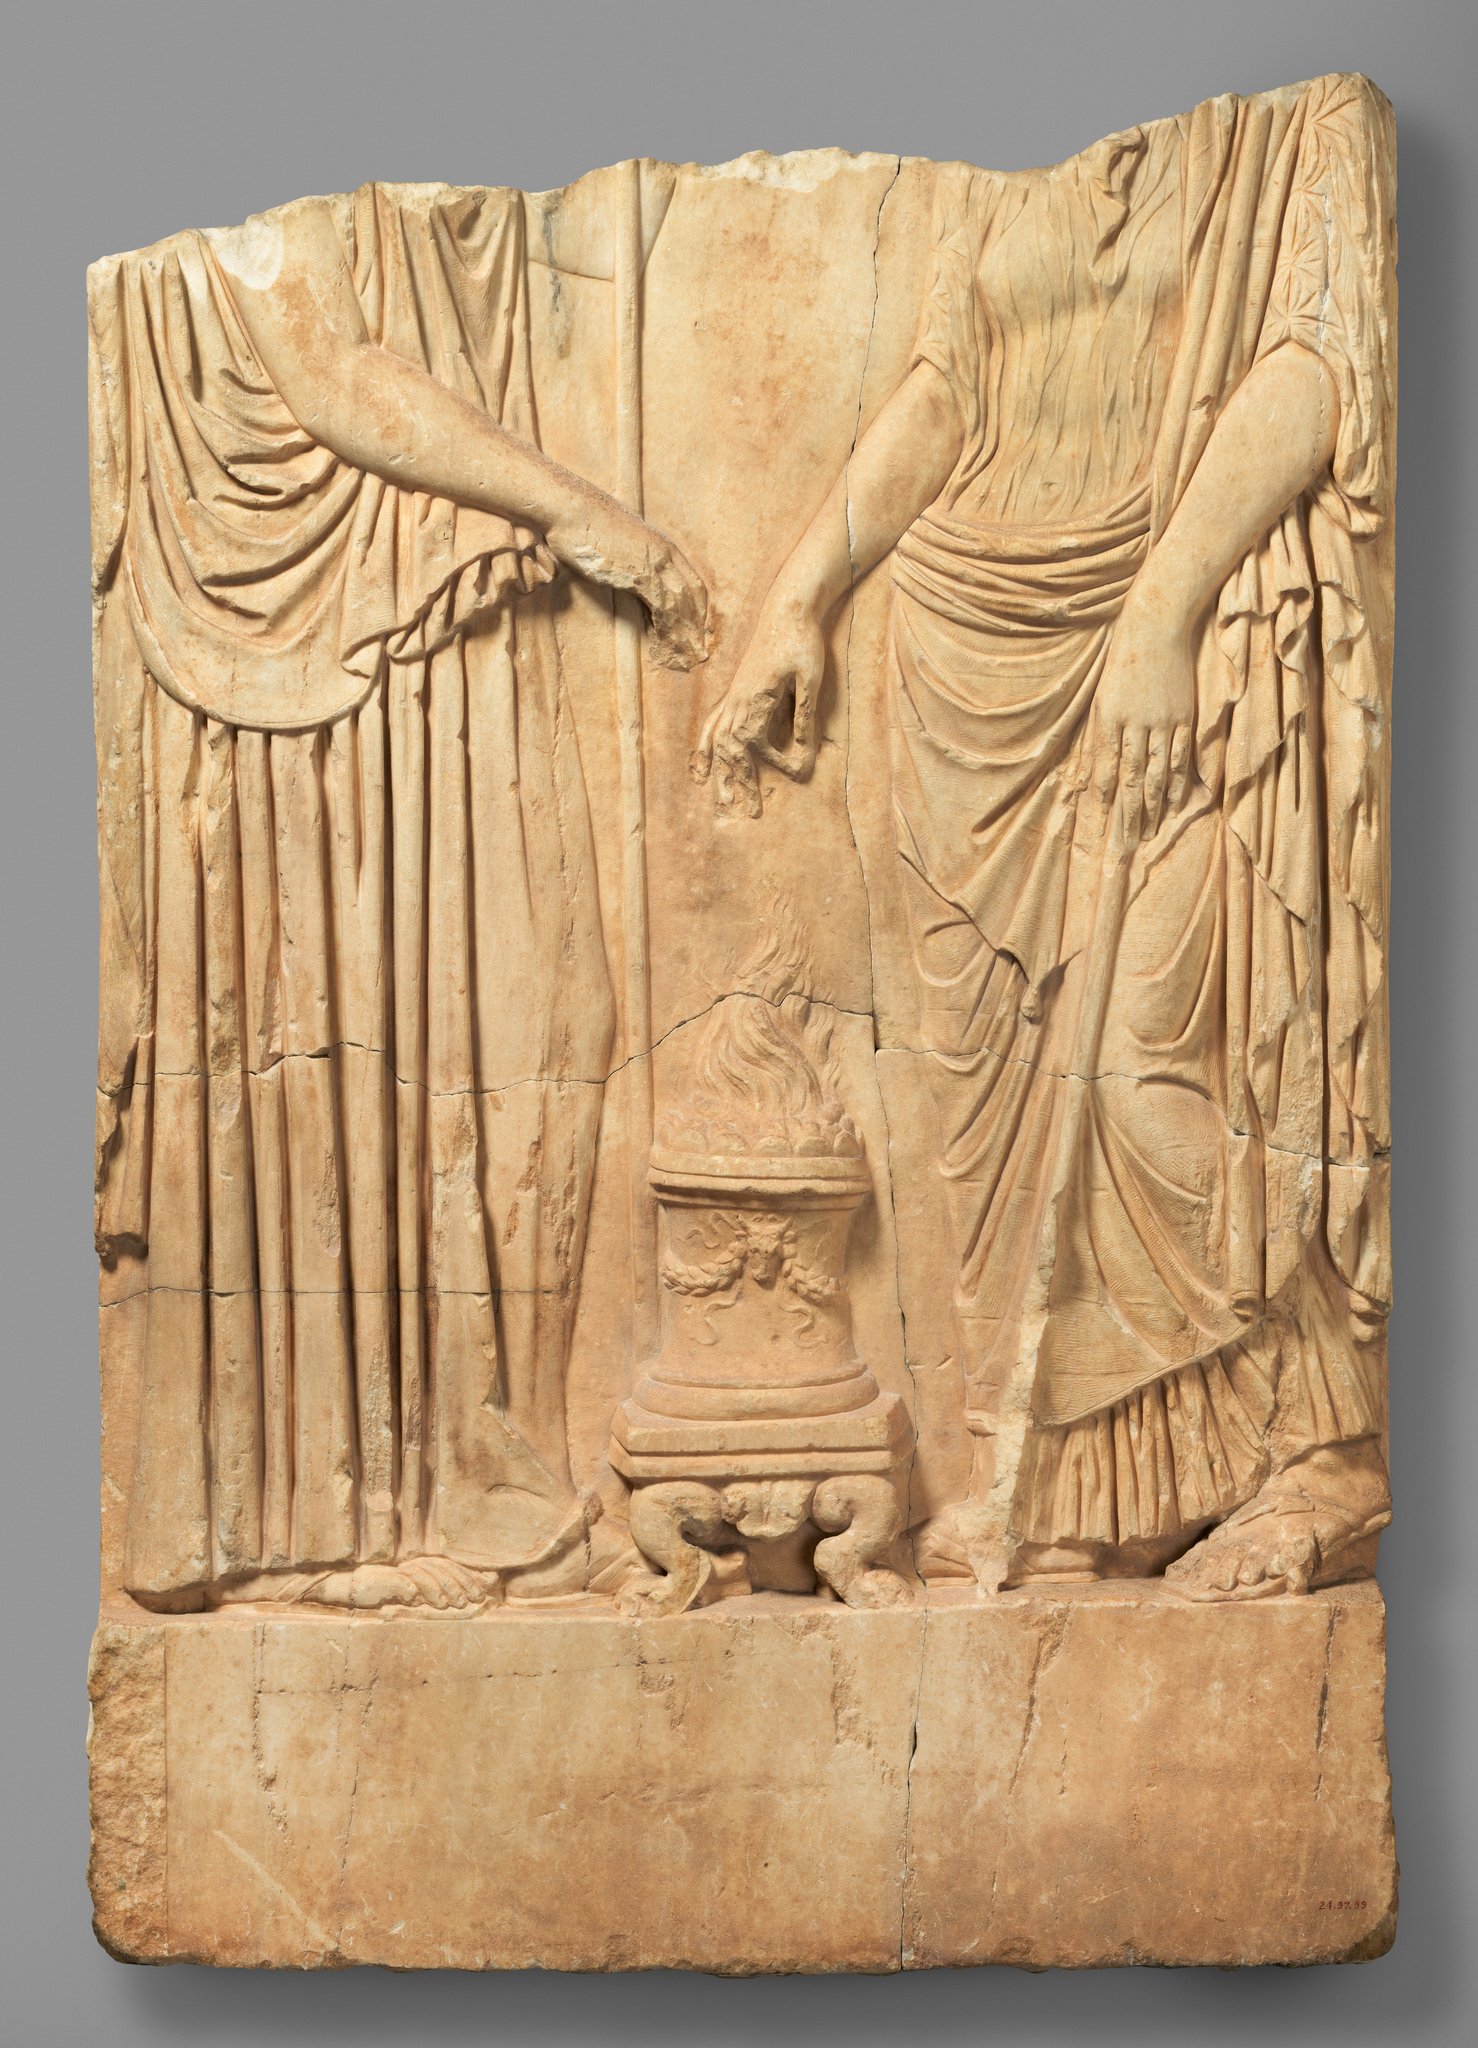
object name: relief fragment with two goddess, lower part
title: Lower part of a marble relief with two goddesses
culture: roman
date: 1-200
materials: marble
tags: goddess,incense burners